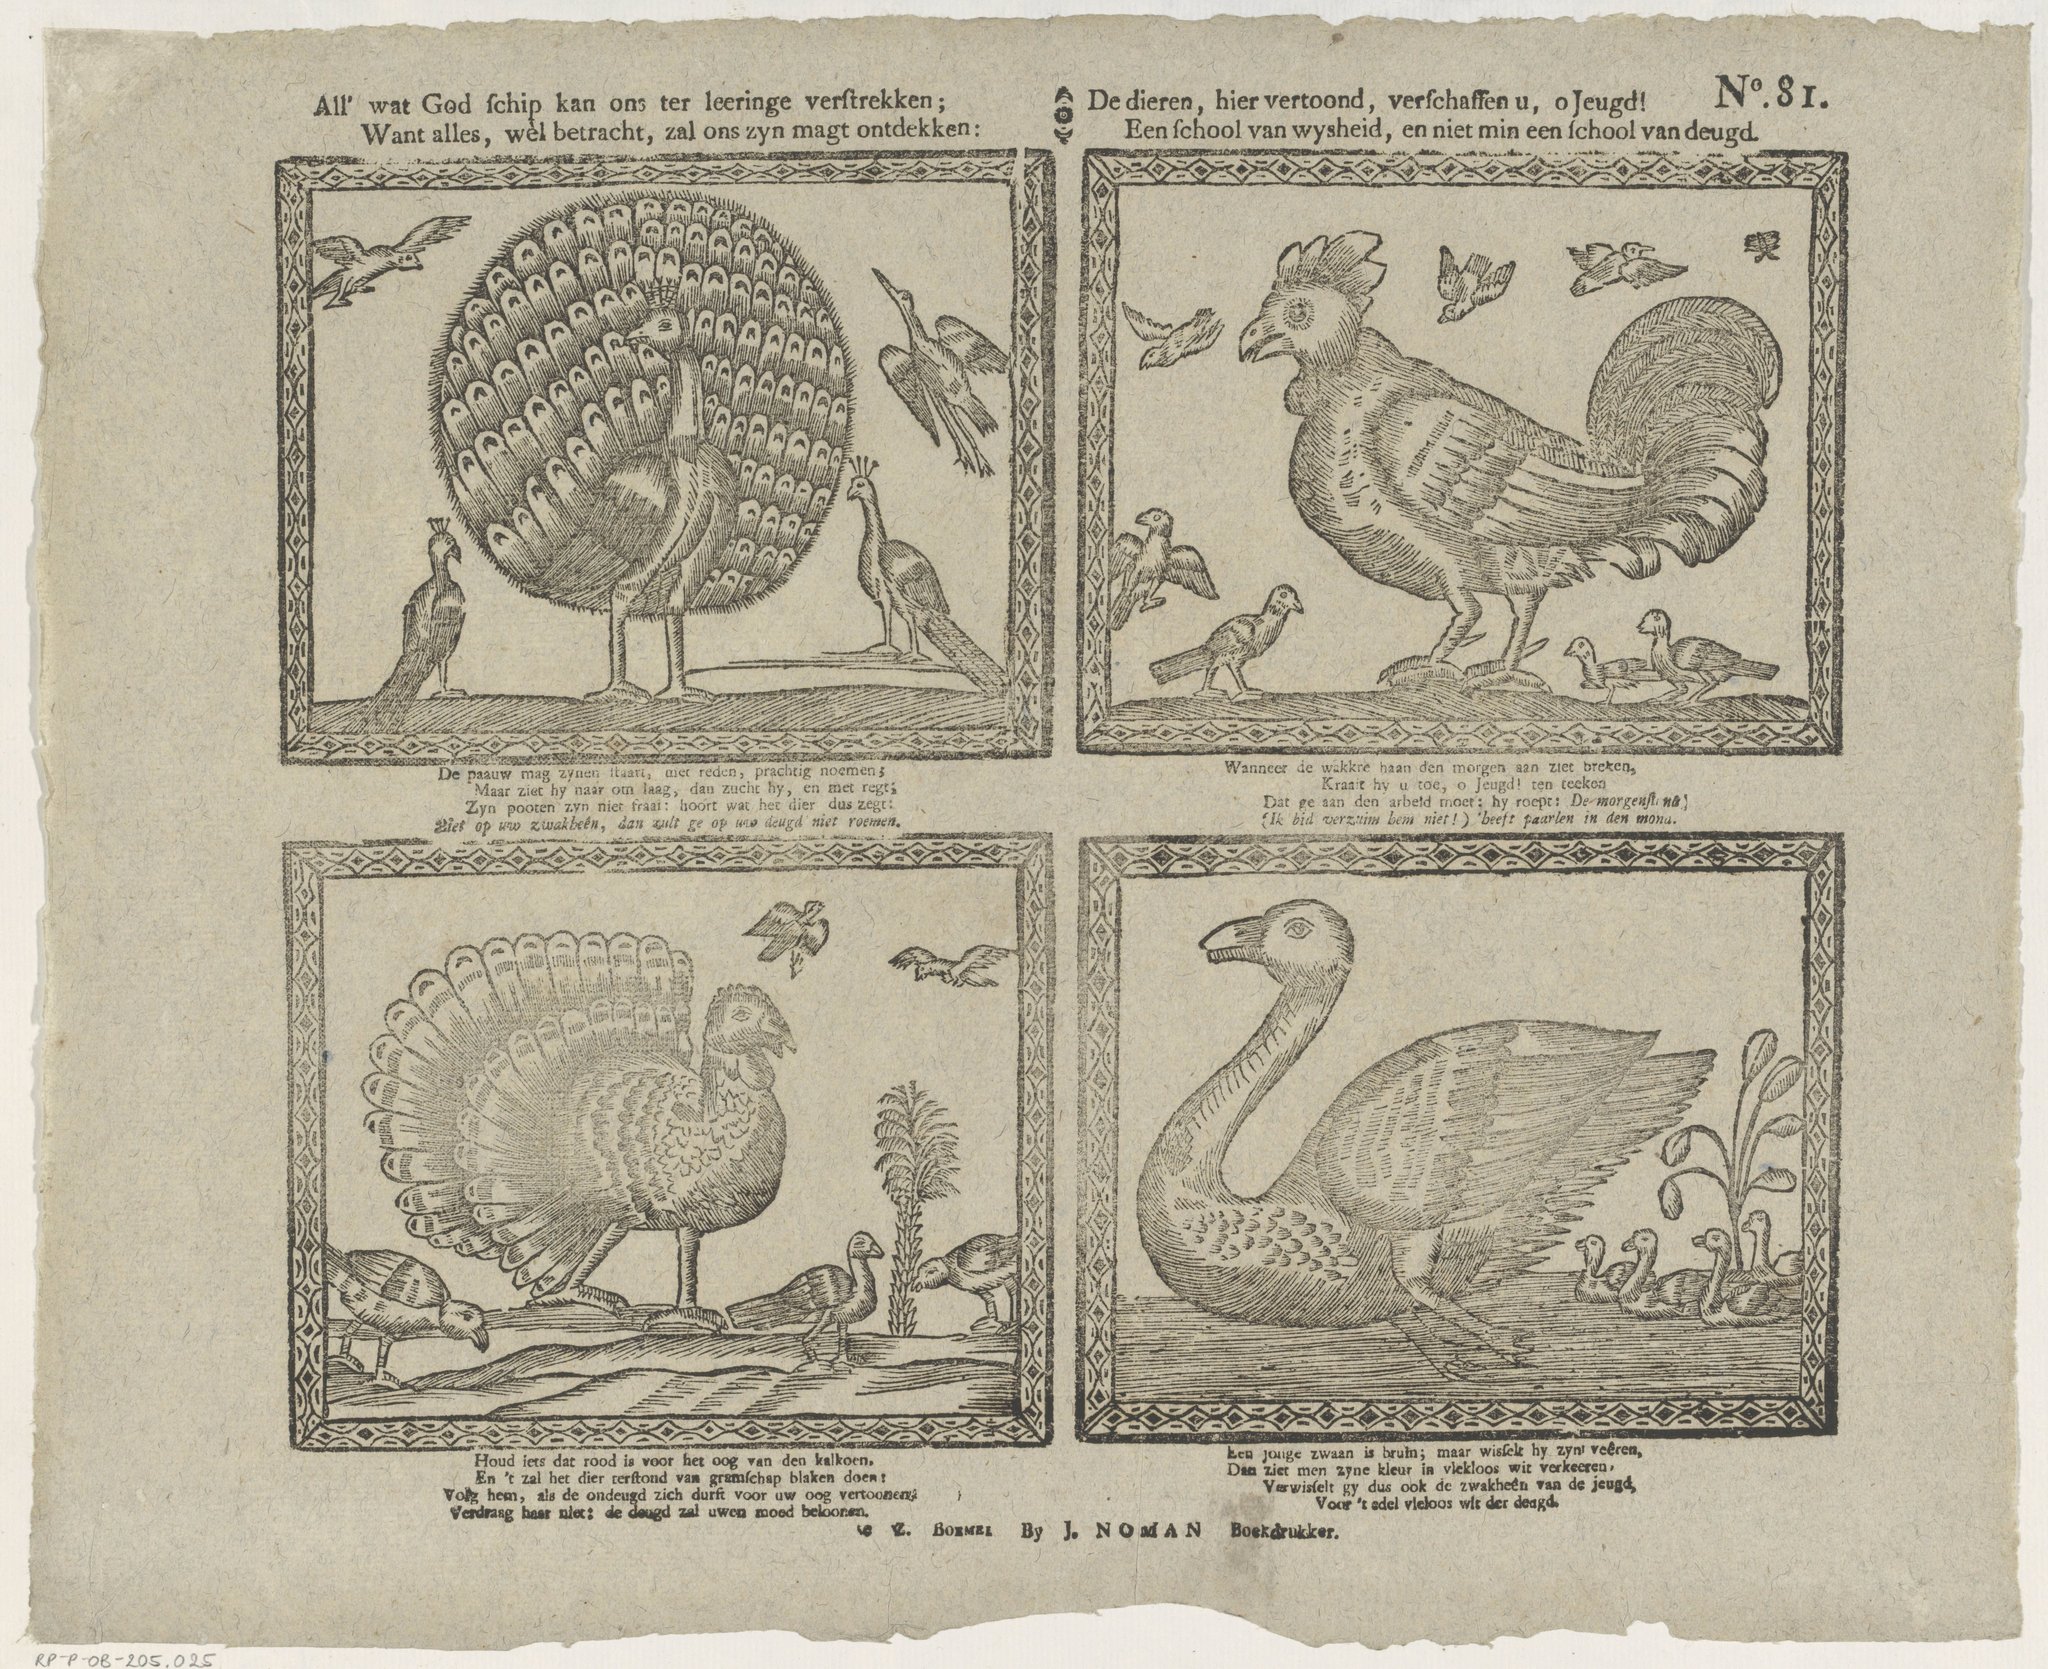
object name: print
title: All' wat God schip kan ons ter leeringe verstrekken; / Want alles, wel betracht, zal ons zyn magt ontdekkehn: / De dieren, hier vertoond, verschaffen u, o jeugd! / Een school van wysheid, en niet min een school van deugd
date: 1806-1830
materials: paper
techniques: letterpress printing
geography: zaltbommel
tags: water-birds: swan, birds, ornamental birds: peacock, fowl (cock, hen, chicken, etc.), walker and runner birds: turkey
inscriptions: collector's mark: Lugt 2760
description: Blad met 4 voorstellingen van vogels: een pauw, een haan, een kalkoen en een zwaan. Onder elke afbeelding een vierregelig vers. Genummerd rechtsboven: No. 81.